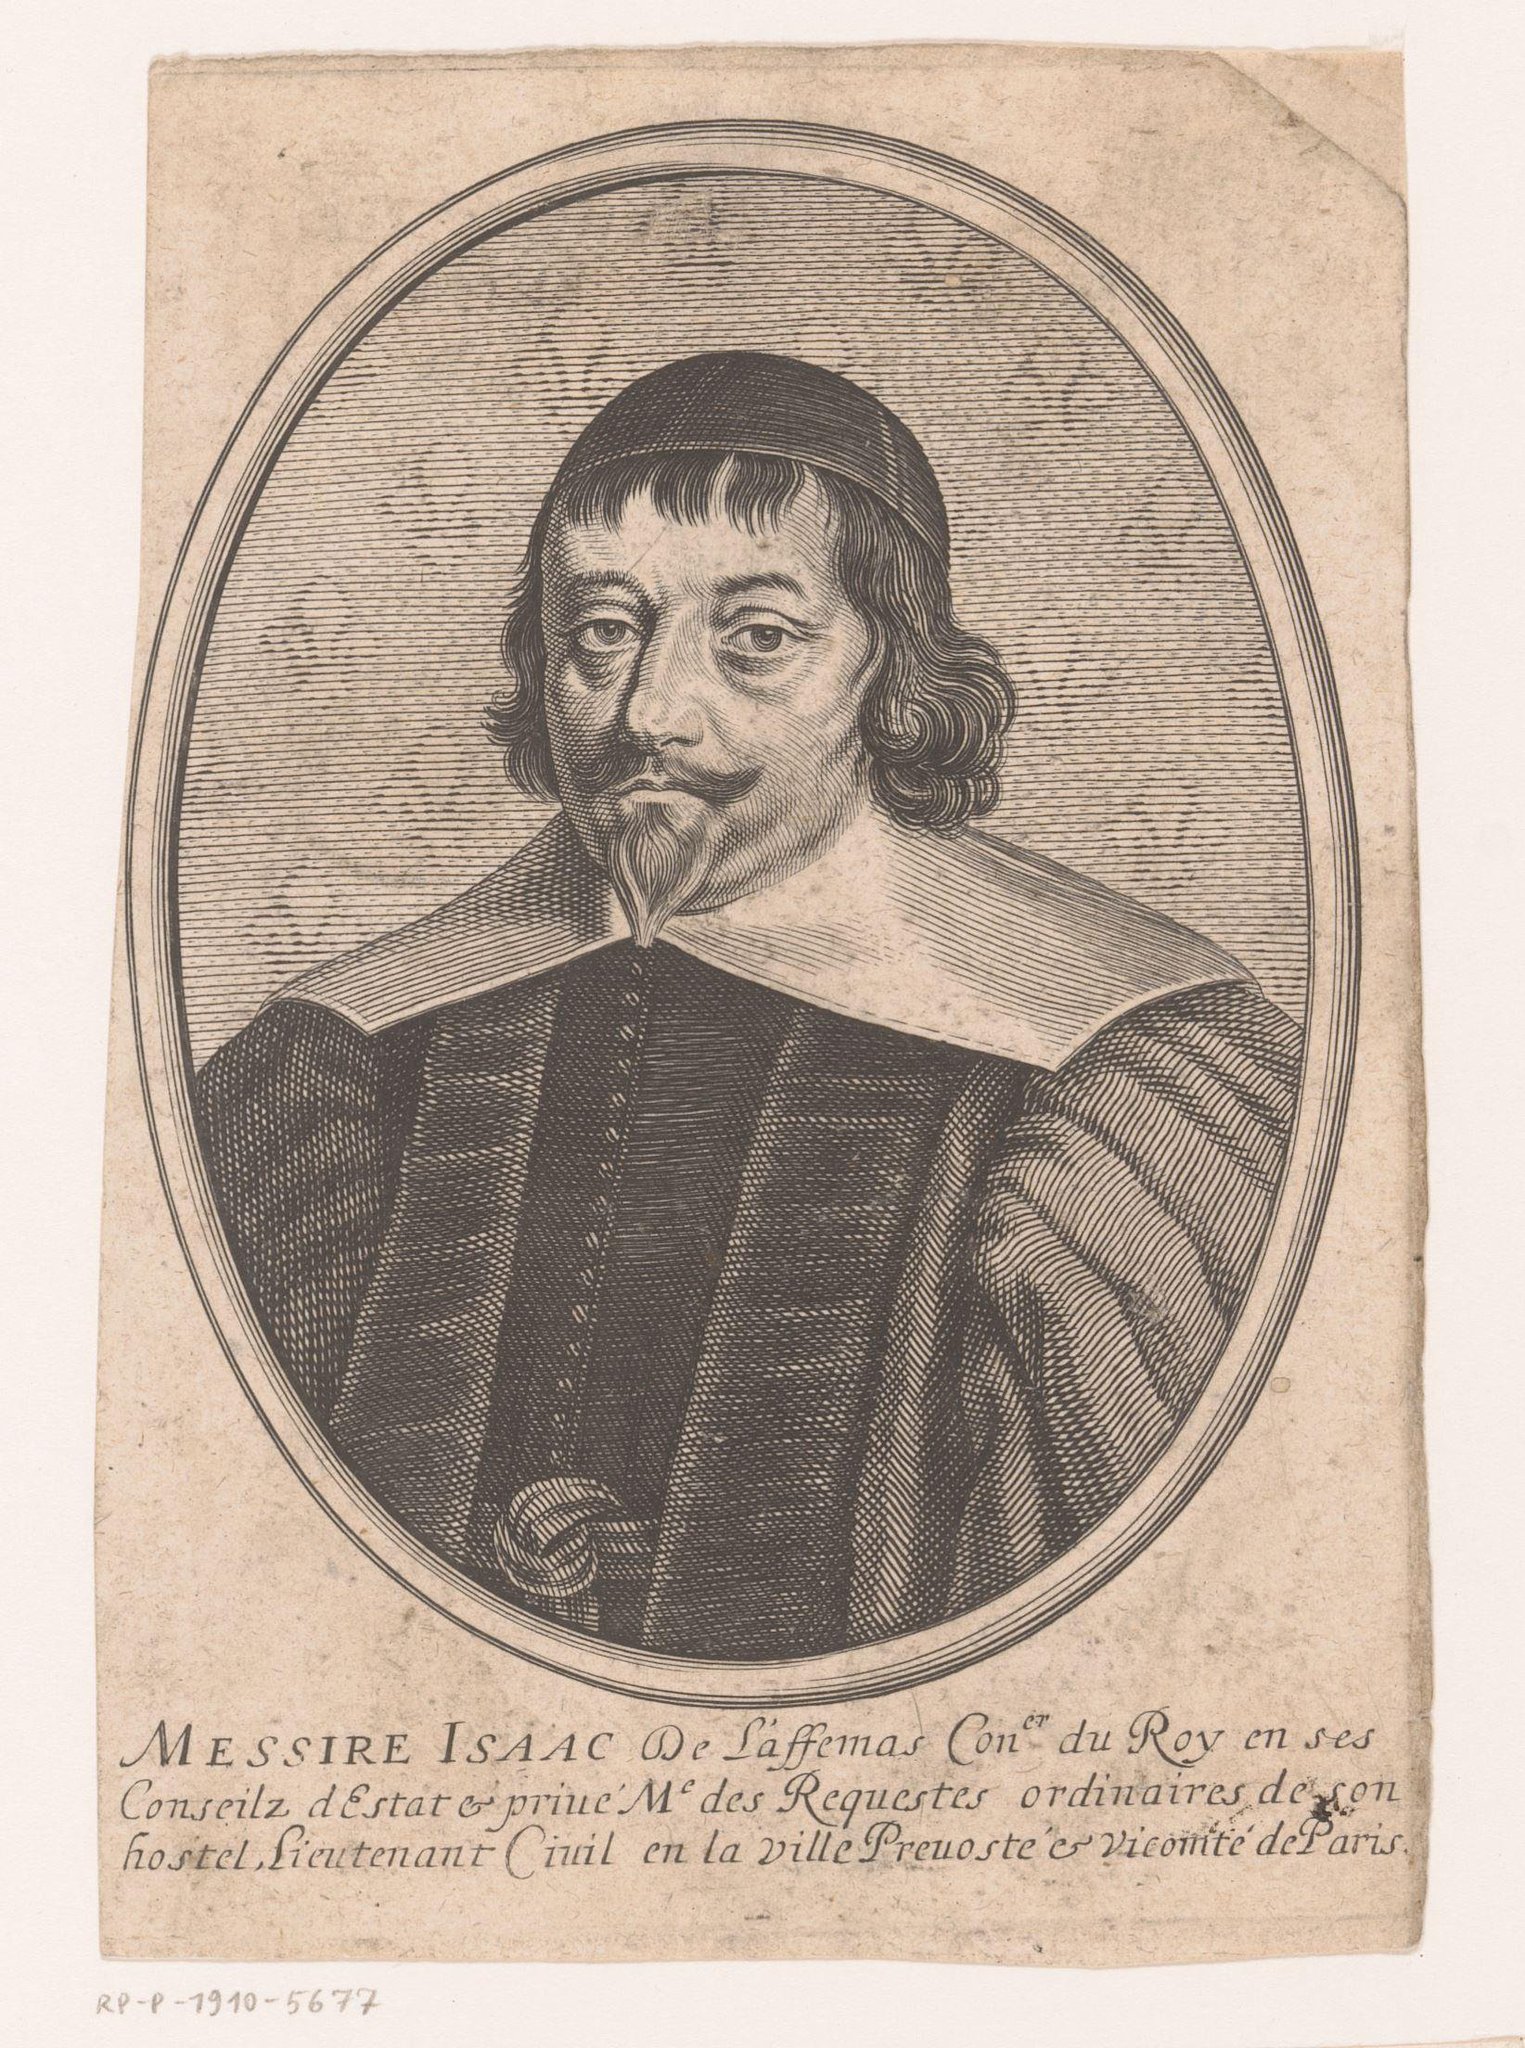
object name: print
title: Portret van Isaac de Laffemas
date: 1637-1668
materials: paper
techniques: engraving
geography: paris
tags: paris, isaac de laffemas, historical persons, portrait of a writer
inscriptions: collector's mark: Lugt 2228